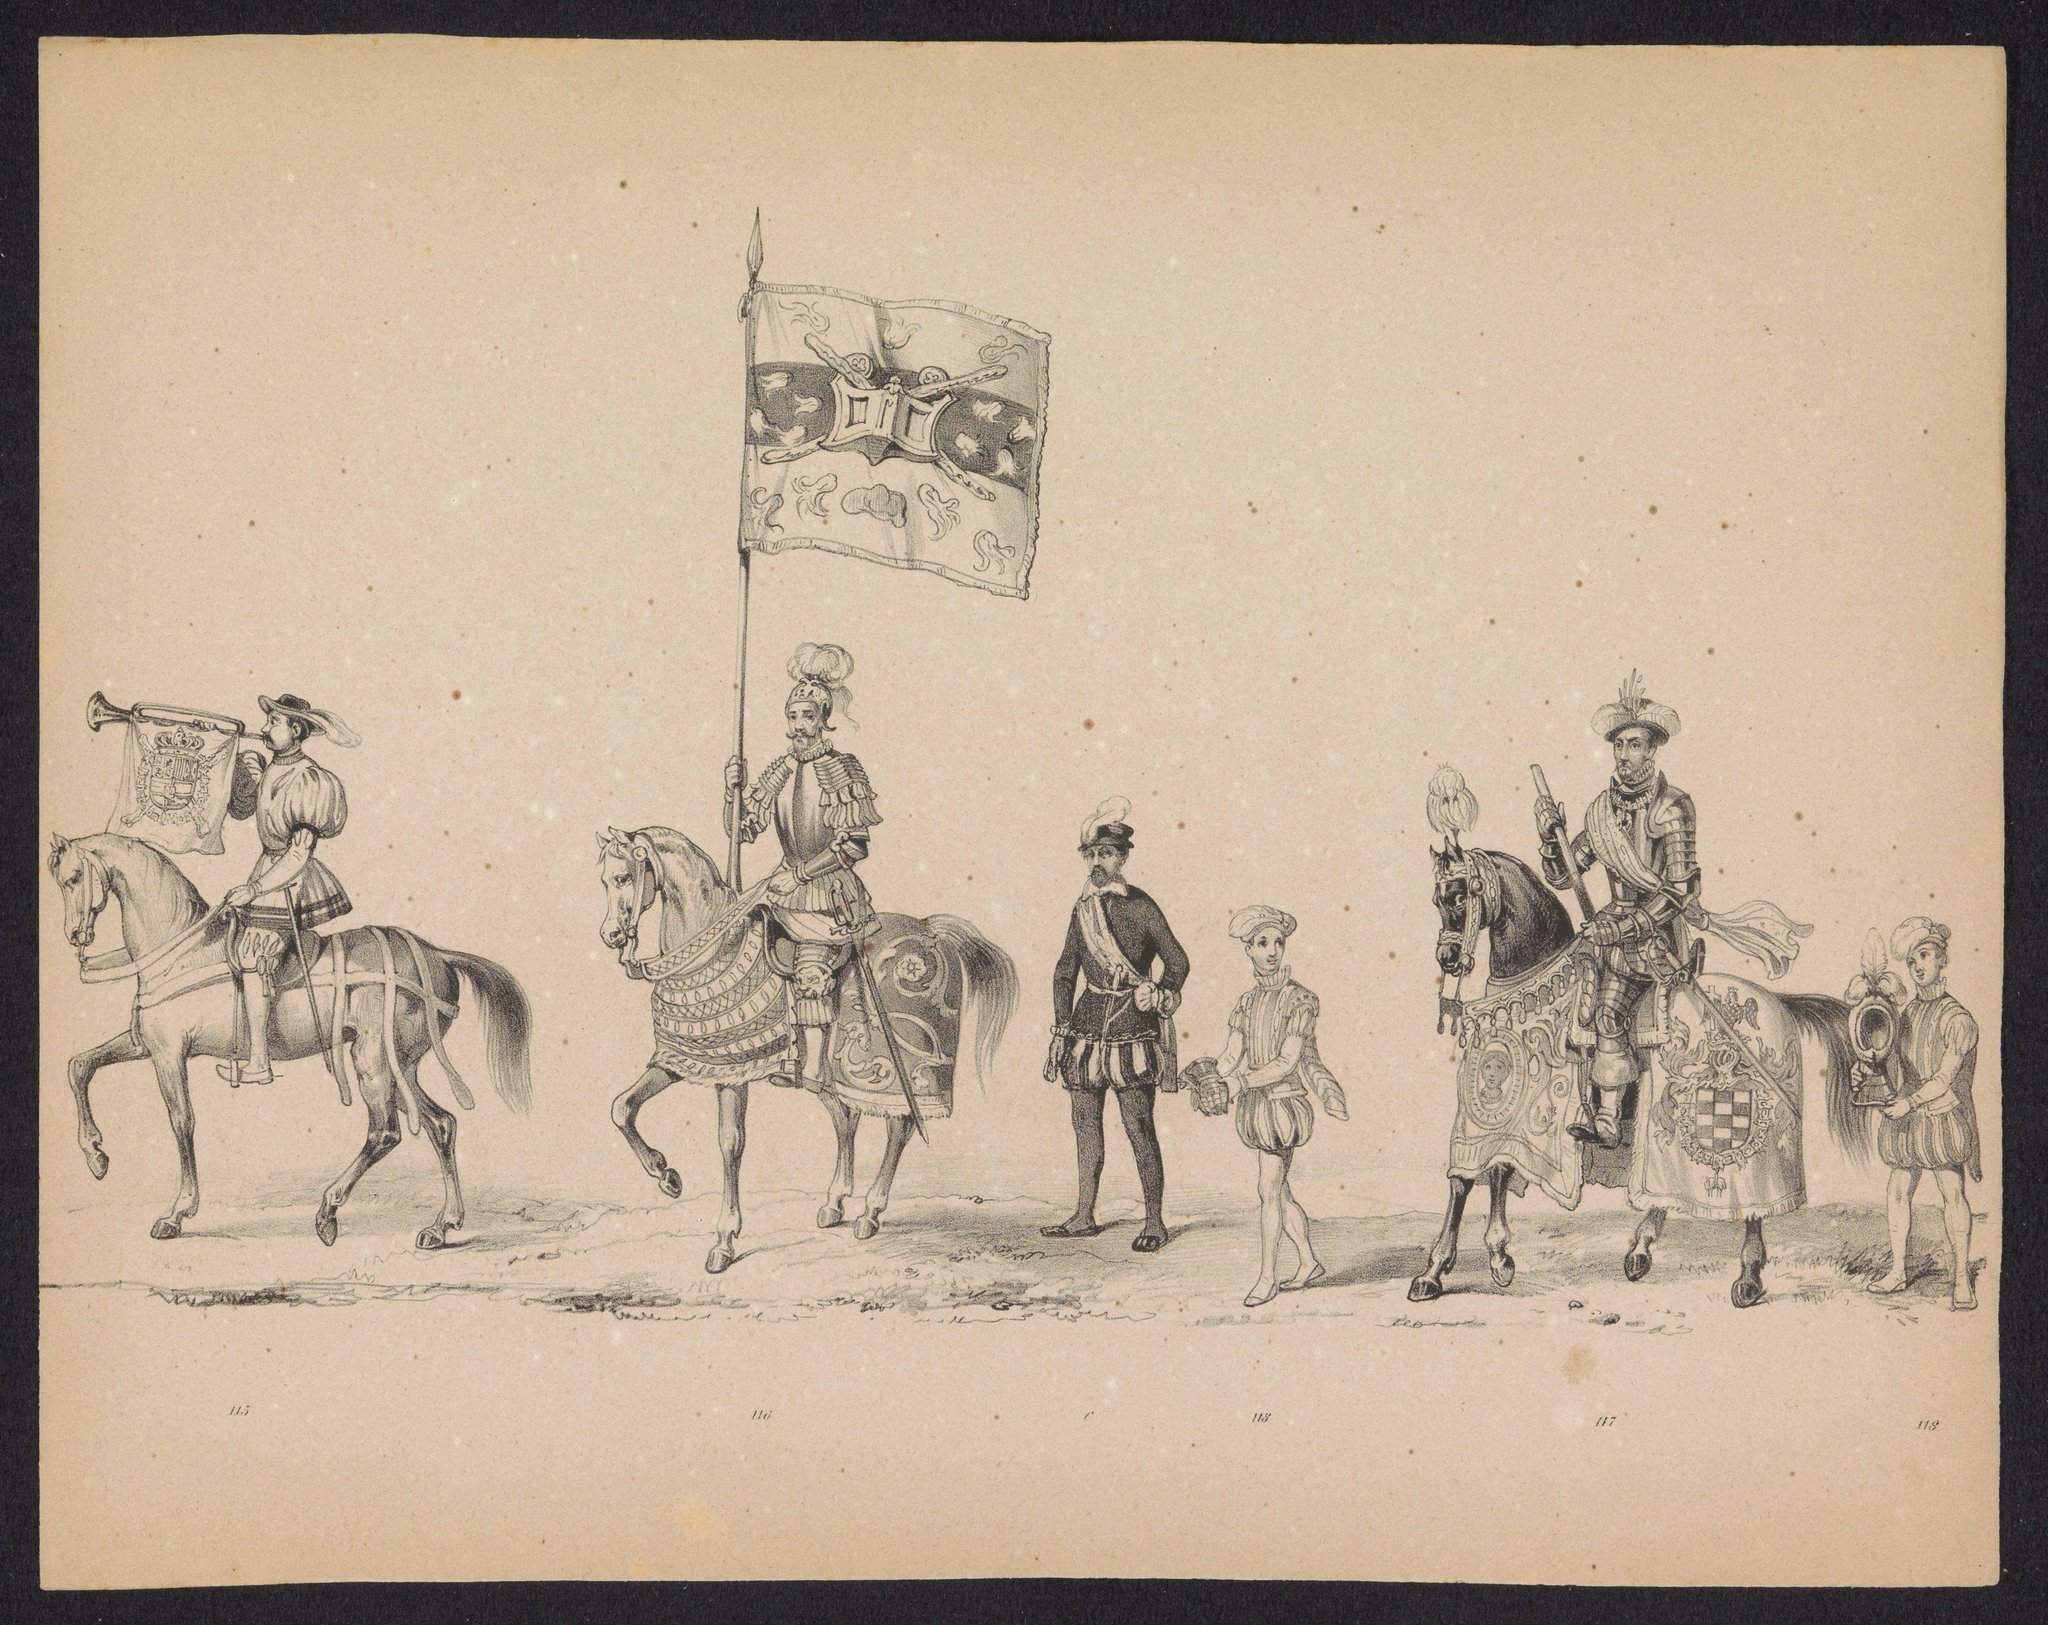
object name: print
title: Maskerade van de Utrechtse studenten, 1846 (plaat 20)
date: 1847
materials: paper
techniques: lithograph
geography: leiden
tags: philip ii of spain, students' pageant, costumes used in pageants, utrecht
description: Historische gekostumeerde optocht van de studenten van de Utrechtse Hogeschool gehouden op 17 juni 1846 ter gelegenheid van het 210-jarig bestaan van de Hogeschool. De optocht verbeeldt de intocht van Filips II in Utrecht op 3 oktober 1549. Plaat met de groepen genummerd 115-118. Onderdeel van de serie van 22 aanelkaar te plakken losse bladen.